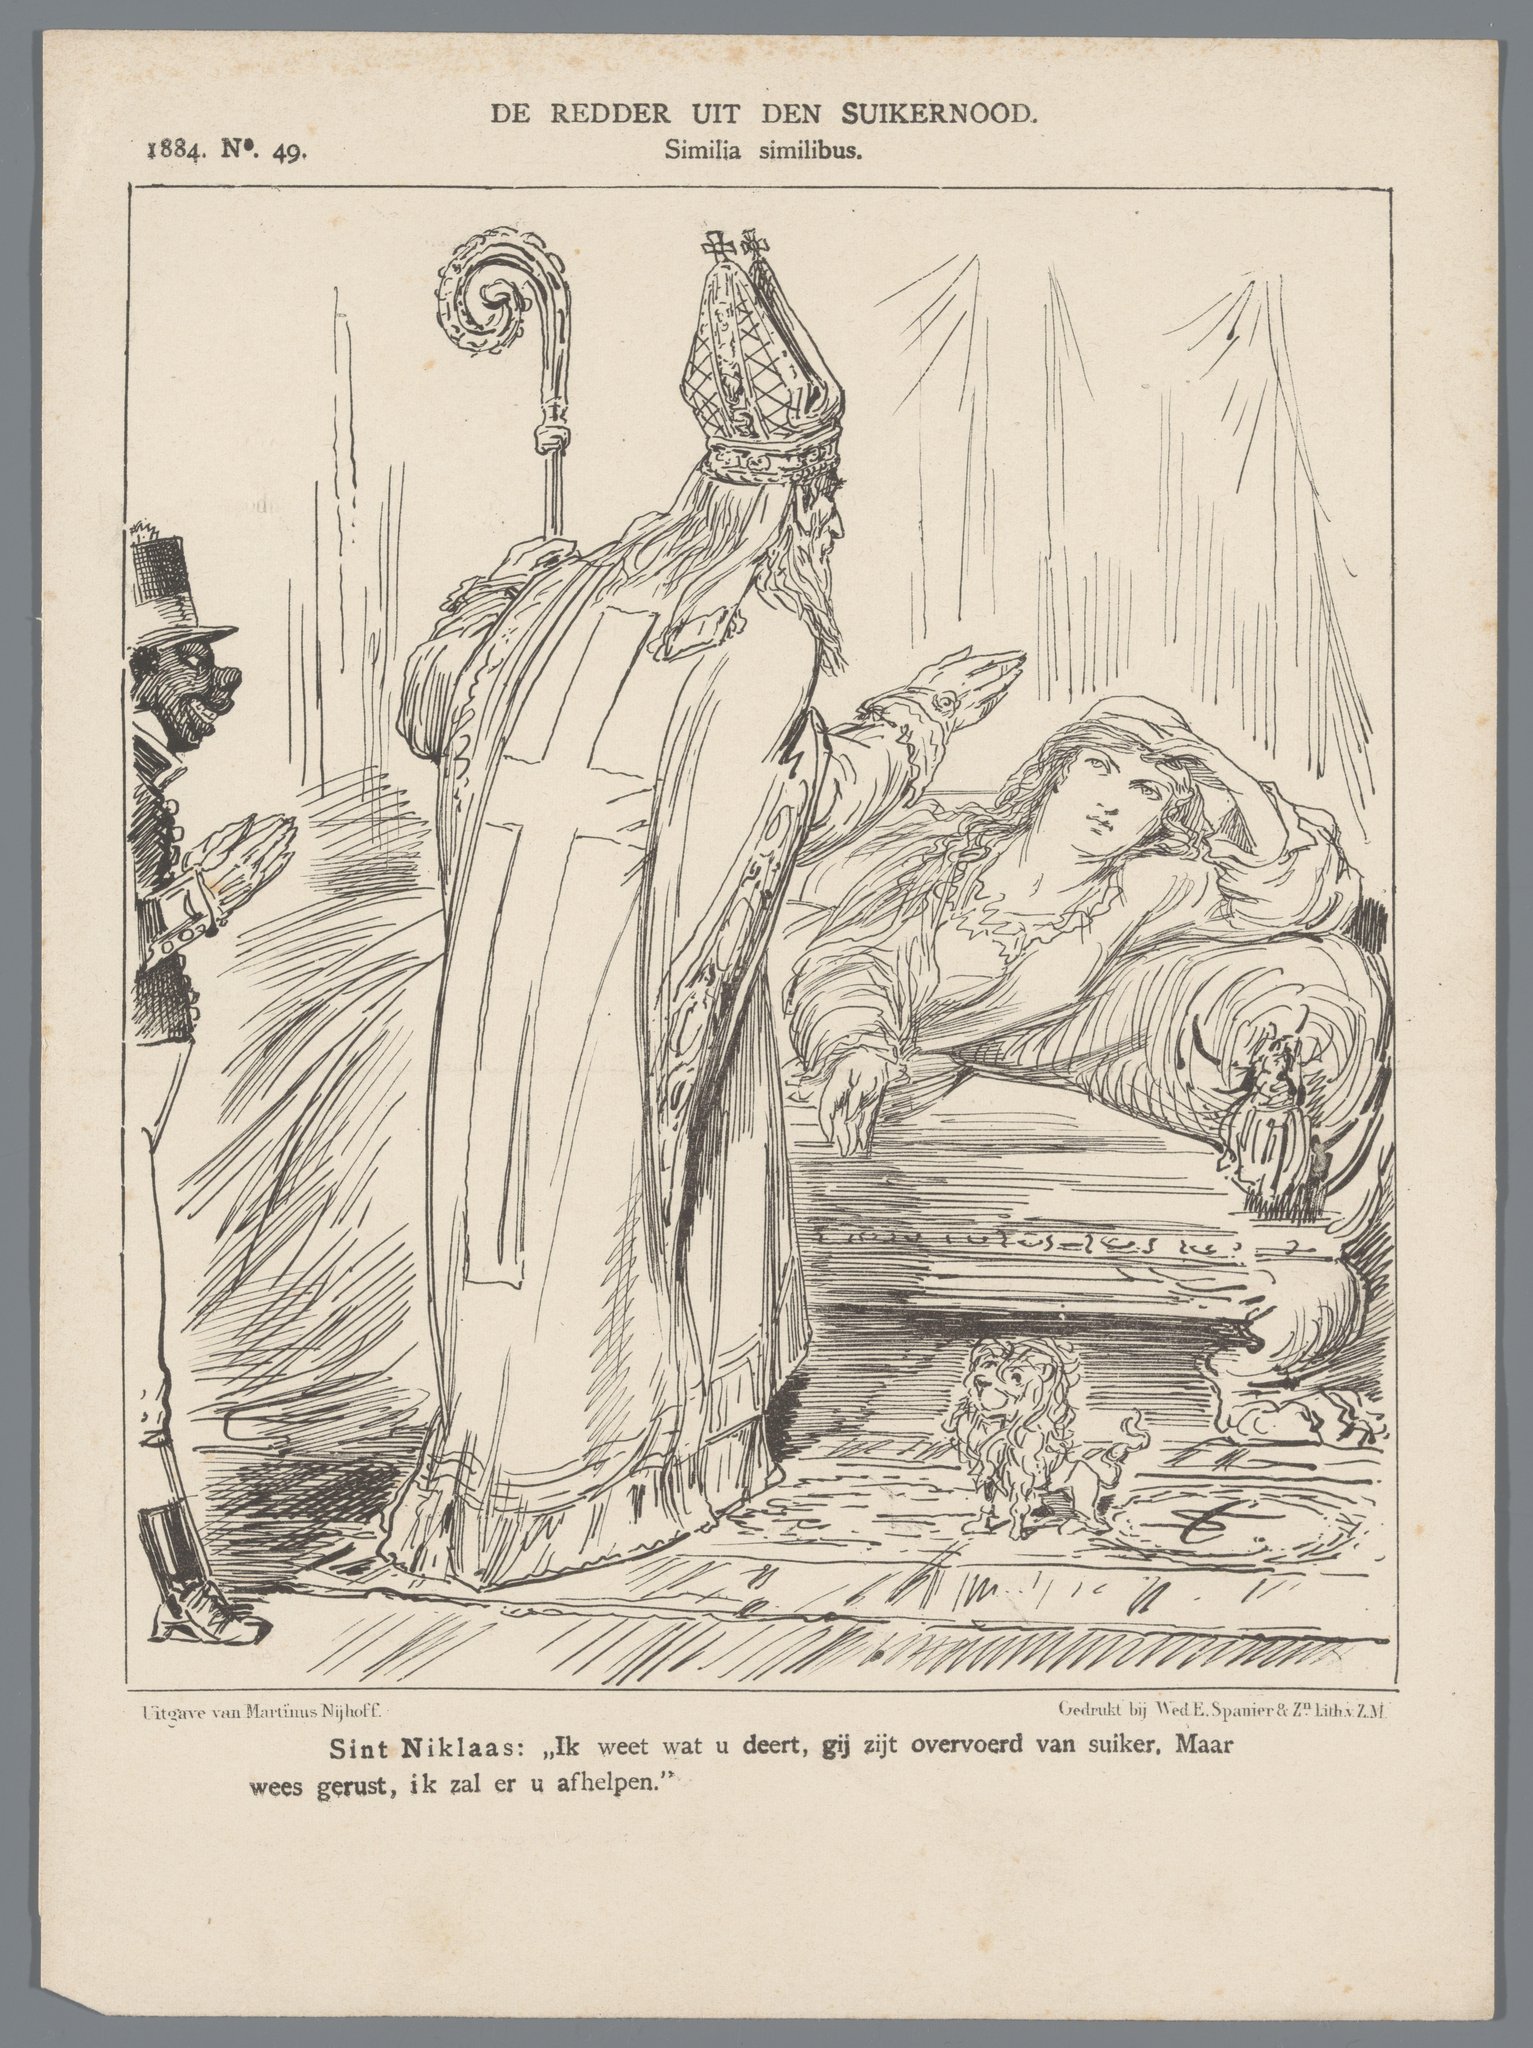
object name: print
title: De redder uit den suikernood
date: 1884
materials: paper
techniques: lithograph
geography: the hague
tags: personifications of countries, nations, states, districts, etc., saint nicholas day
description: Spotprent over de suikernood: Sinterklaas en Zwarte Piet op bezoek bij de zieke Nederlandse Maagd. Plaat verschenen bij het weekblad De Nederlandsche Spectator, nr. 49, 1884.